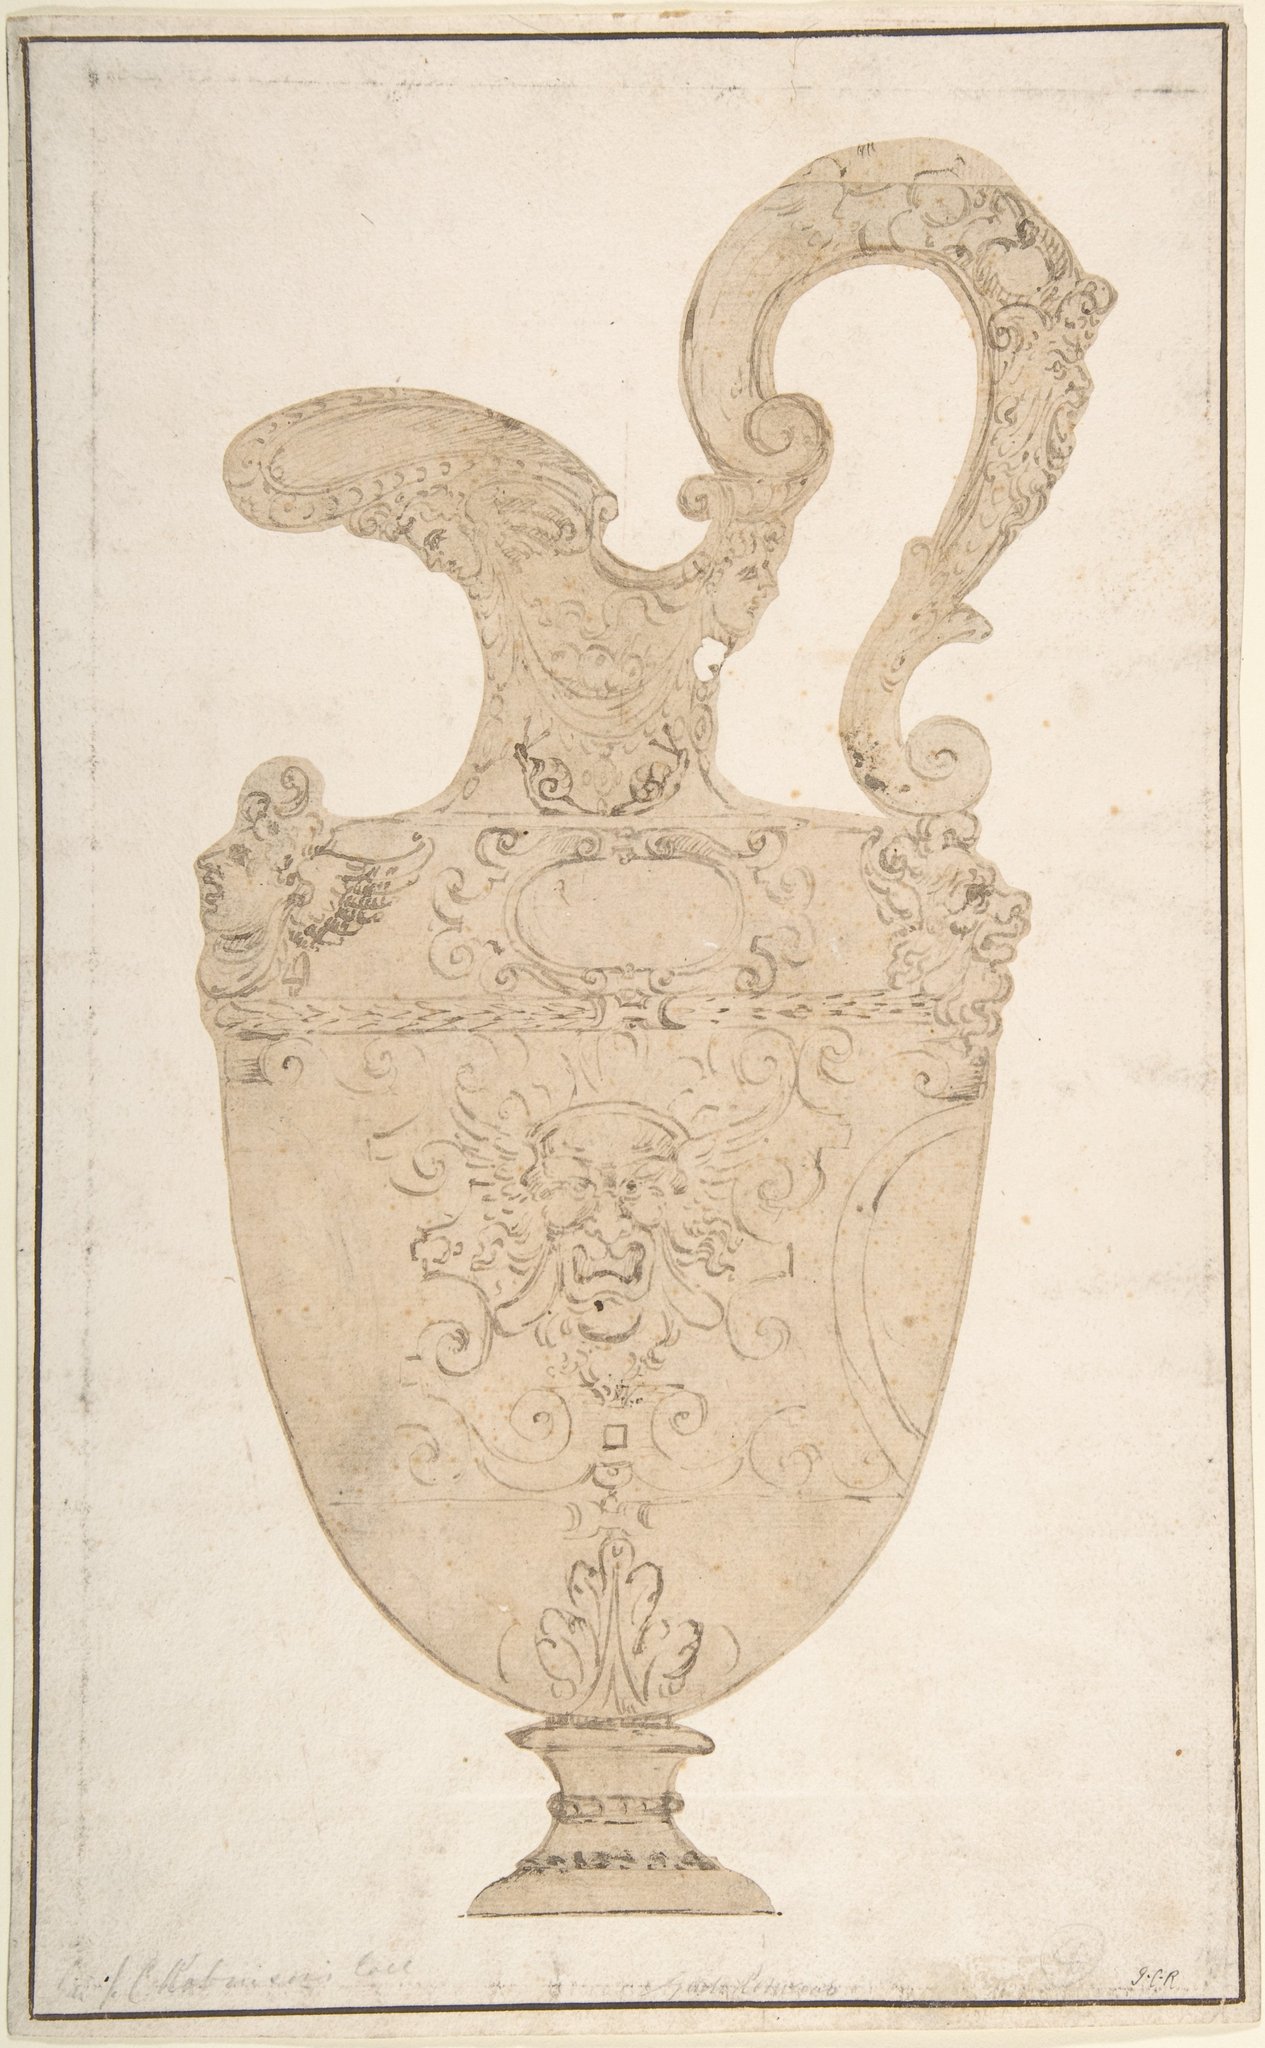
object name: drawing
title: Design of Antique Pitcher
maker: anonymous, italian, 16th century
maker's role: artist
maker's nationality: italian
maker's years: 1500-1600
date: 1501-1600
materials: ink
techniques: pen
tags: pitchers